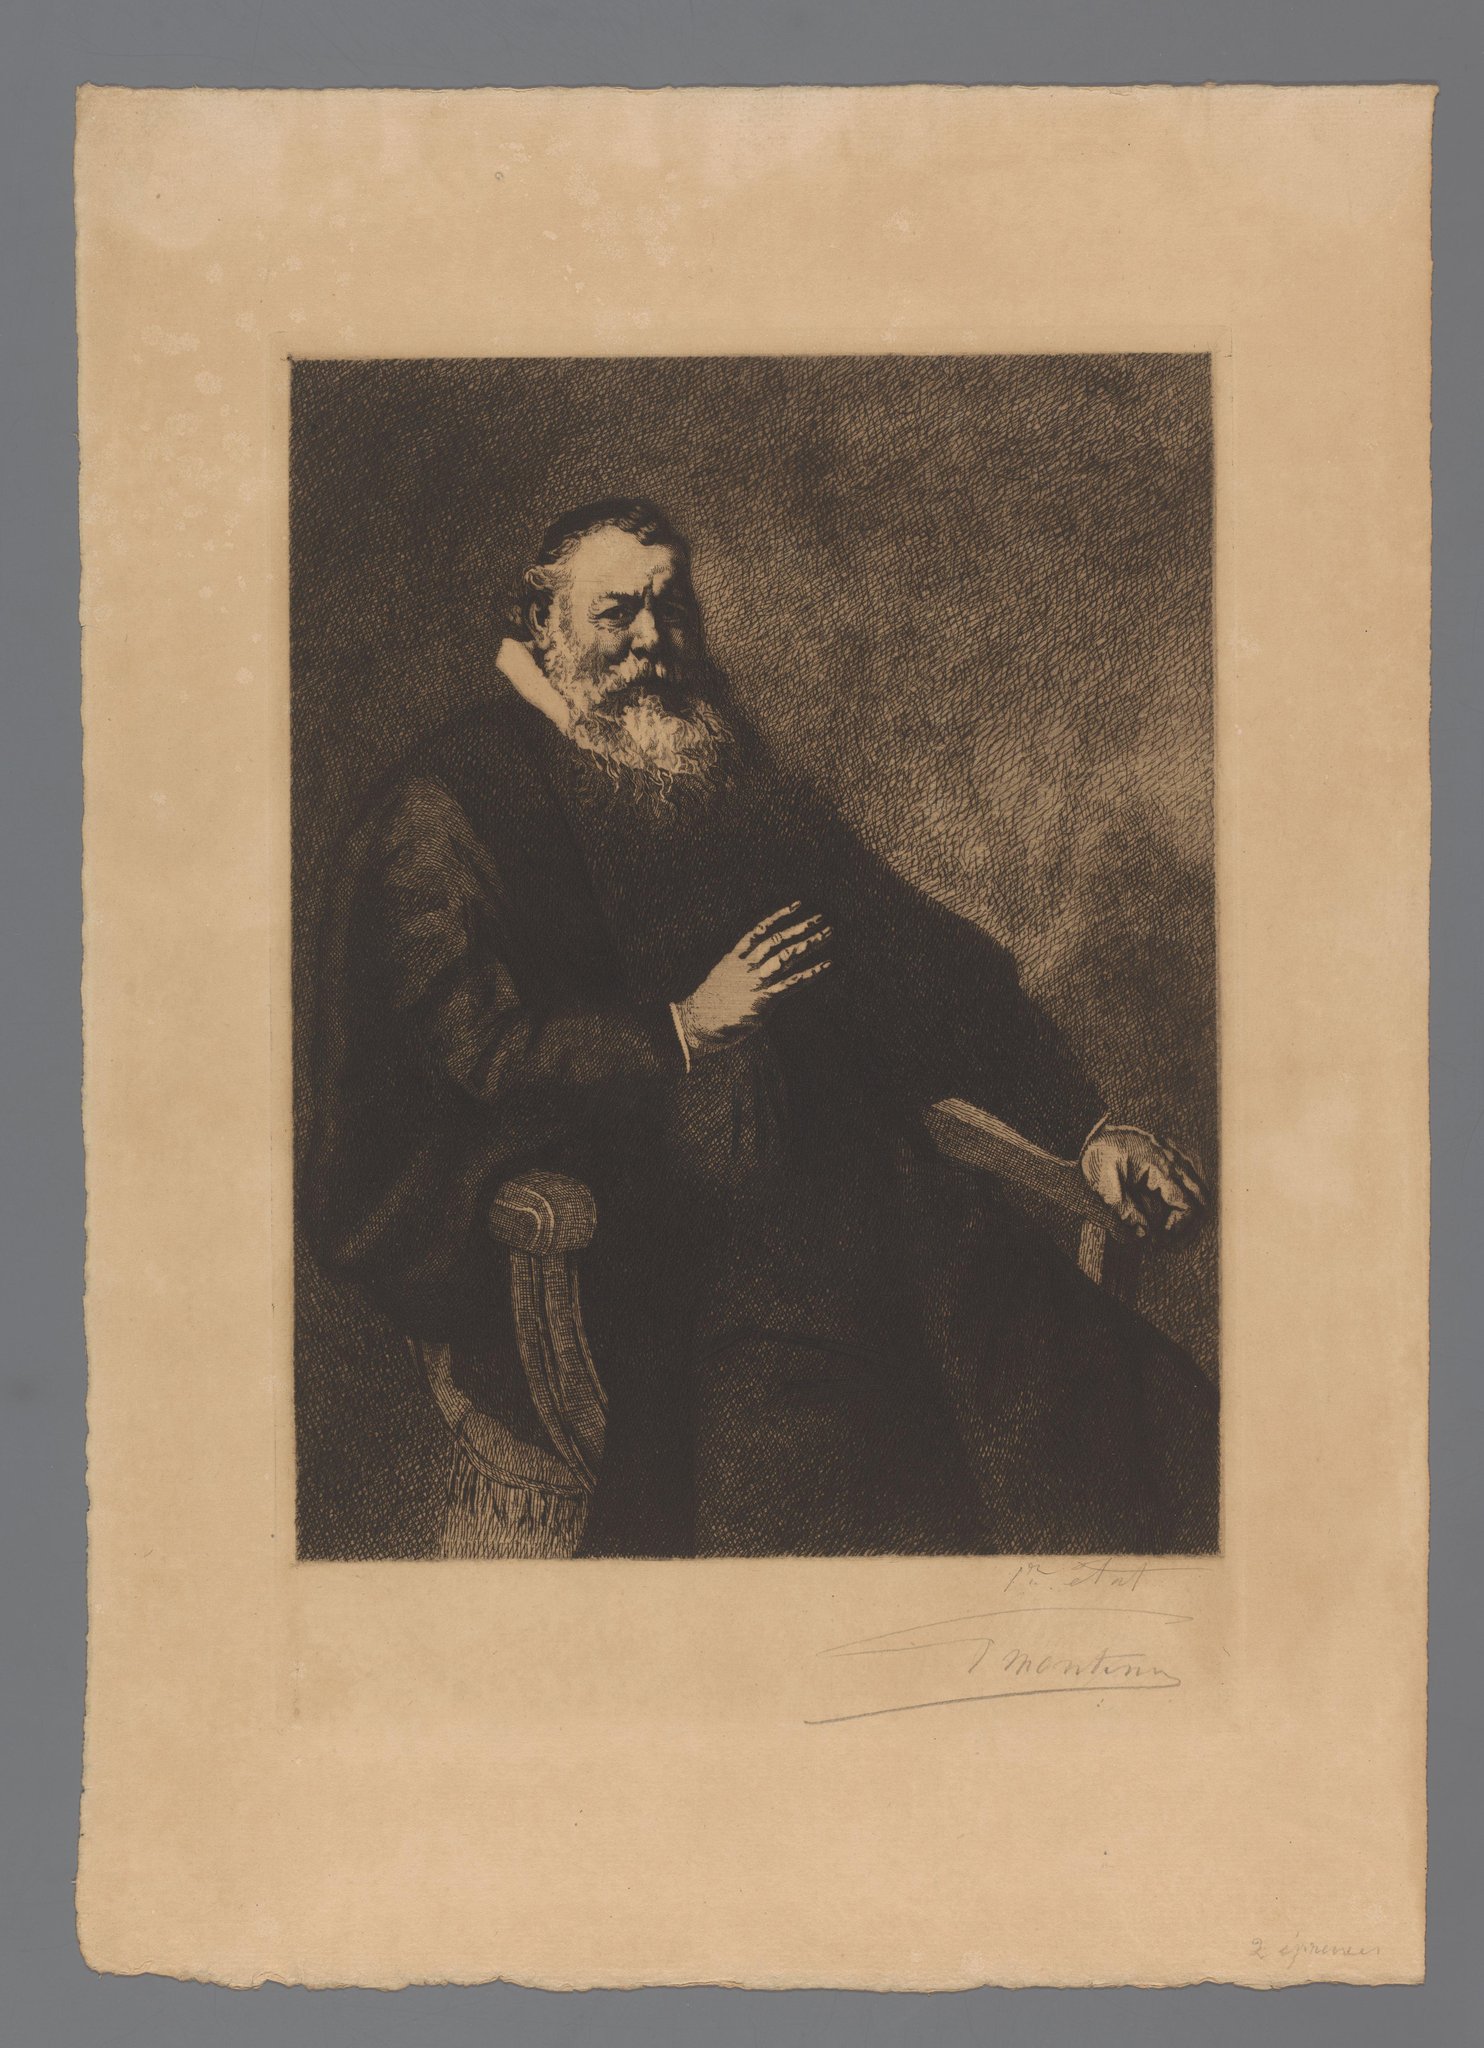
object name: print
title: Portret van een onbekende man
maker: georges montenez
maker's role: print maker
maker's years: 1873-1930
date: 1894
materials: paper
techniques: etching, intaglio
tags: adult man, historical persons, chair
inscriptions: inscription: ‘1e état’, collector's mark: Lugt 2228